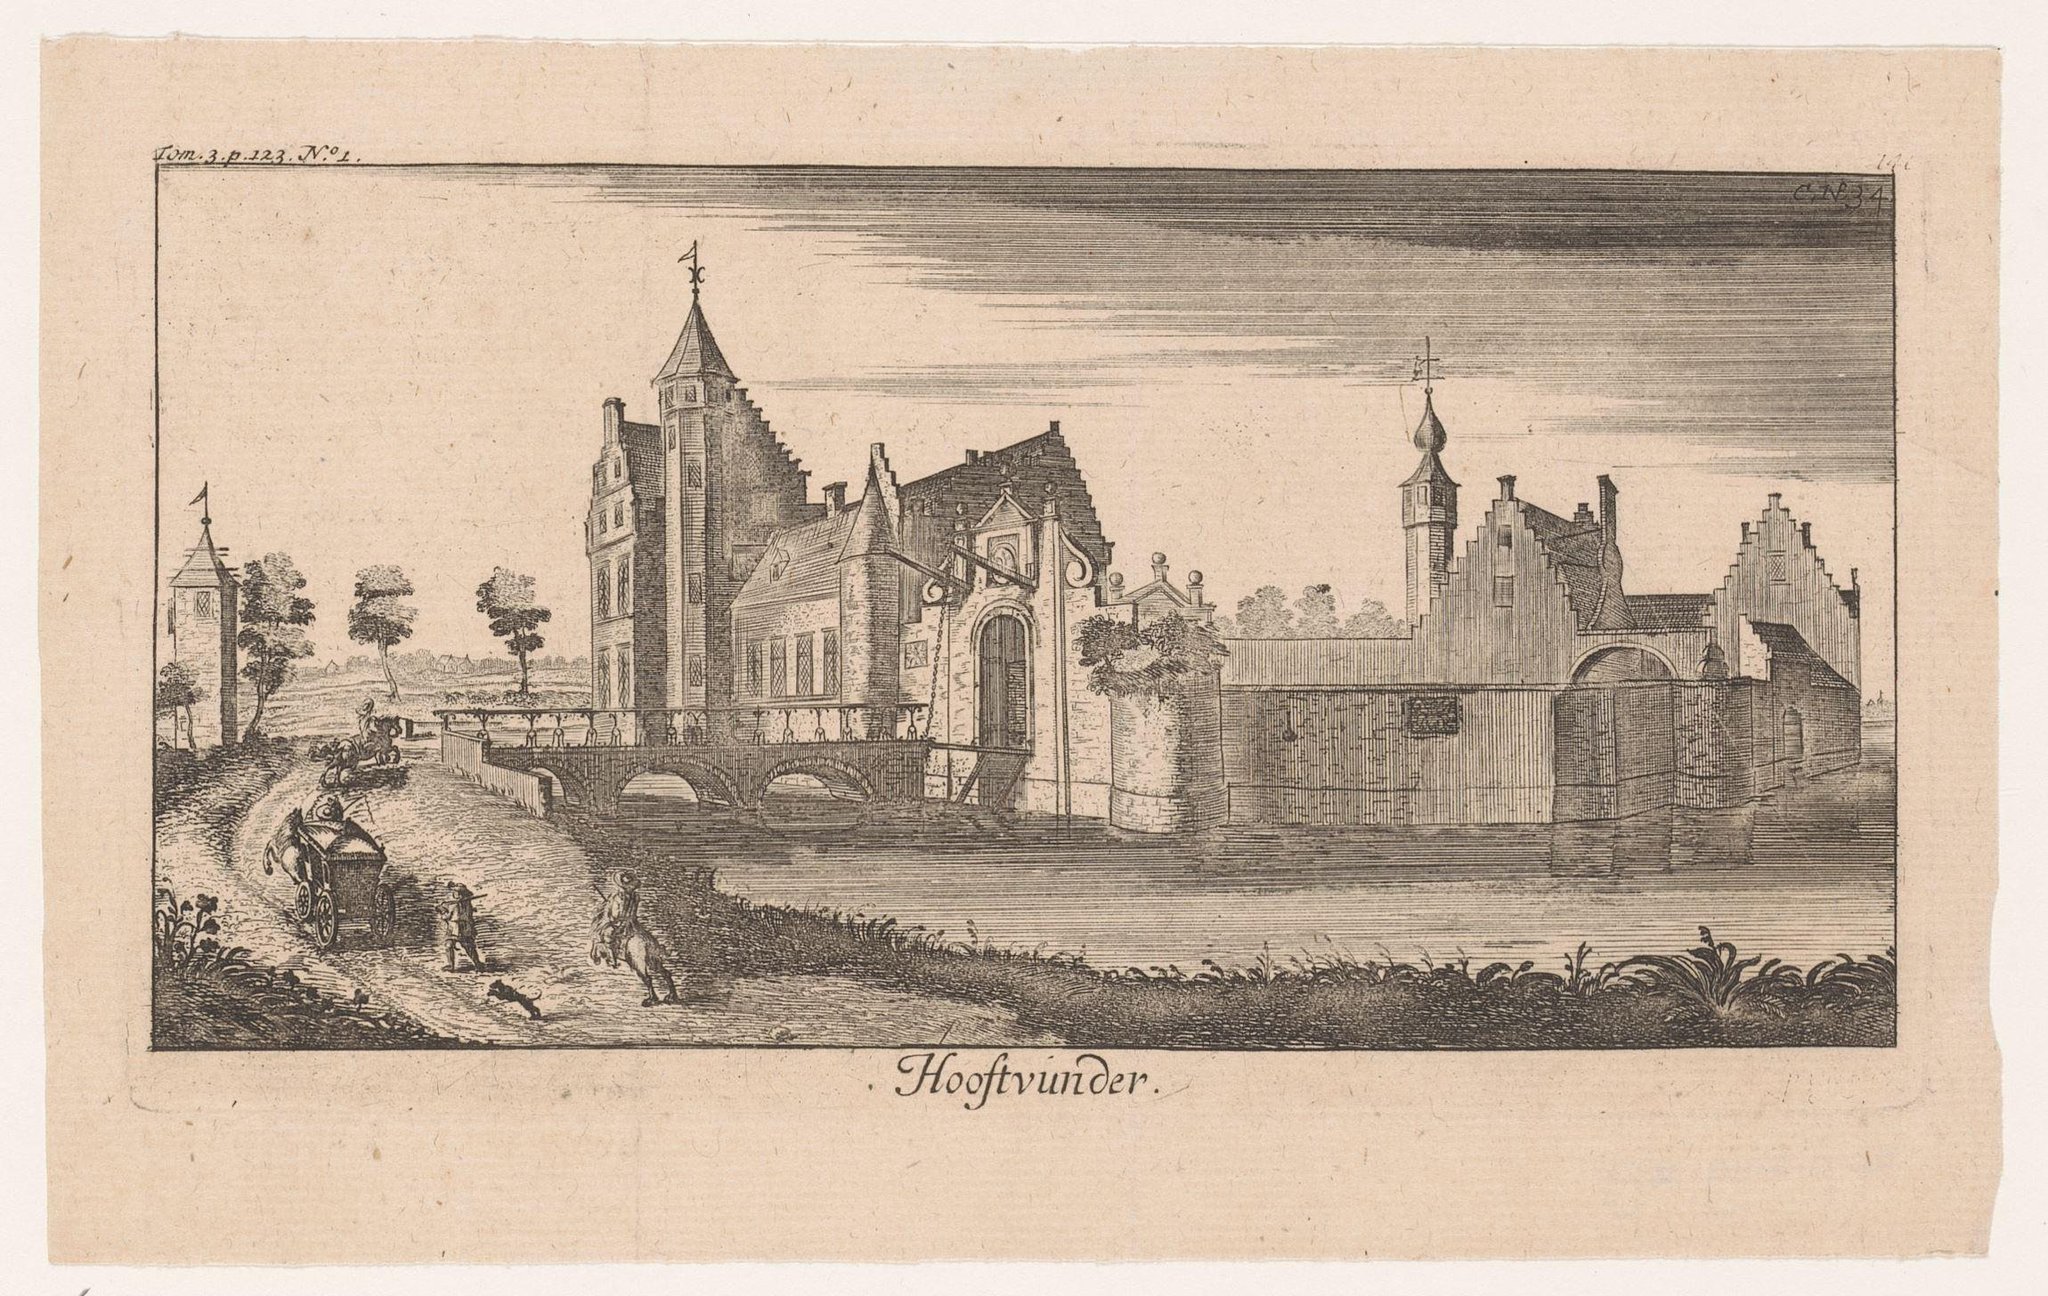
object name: print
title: Gezicht op het kasteel Sterckshof in Deurne, Antwerpen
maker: Anonymous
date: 1678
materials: paper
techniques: engraving, etching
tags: castle, landscape with tower or castle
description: Van deze prent bestaan in ieder geval vijf staten. De eerste staat is gebruikt in Jacques le Roys 'Notitia Marchionatus Sacri Romani Imperii (…)' uit 1678. De tweede en derde staat komt voor in latere uitgaven van Le Roys werk (tweede: 1692, 1699, 1705, 1706; derde: 1730). De vierde staat is gebruikt in Philippe de Cantillons 'Delices du Brabant et de ses campagnes (…)' (1757). De huidige (vijfde) staat komt voor in: Cantillon, Philippe de. Vermakelykheden van Brabant, en deszelfs onderhoorige landen (…). 4 dln. 1e druk. Amsterdam: David Weege, 1770, dl. 3. En in: Cantillon, Philippe de. Vermakelykheden van Brabant, en deszelfs onderhoorige landen (…). 4 dln. 2e druk. Utrecht: Gijsbert Tieme van Paddenburg en Justus Visch, 1777, dl. 3.